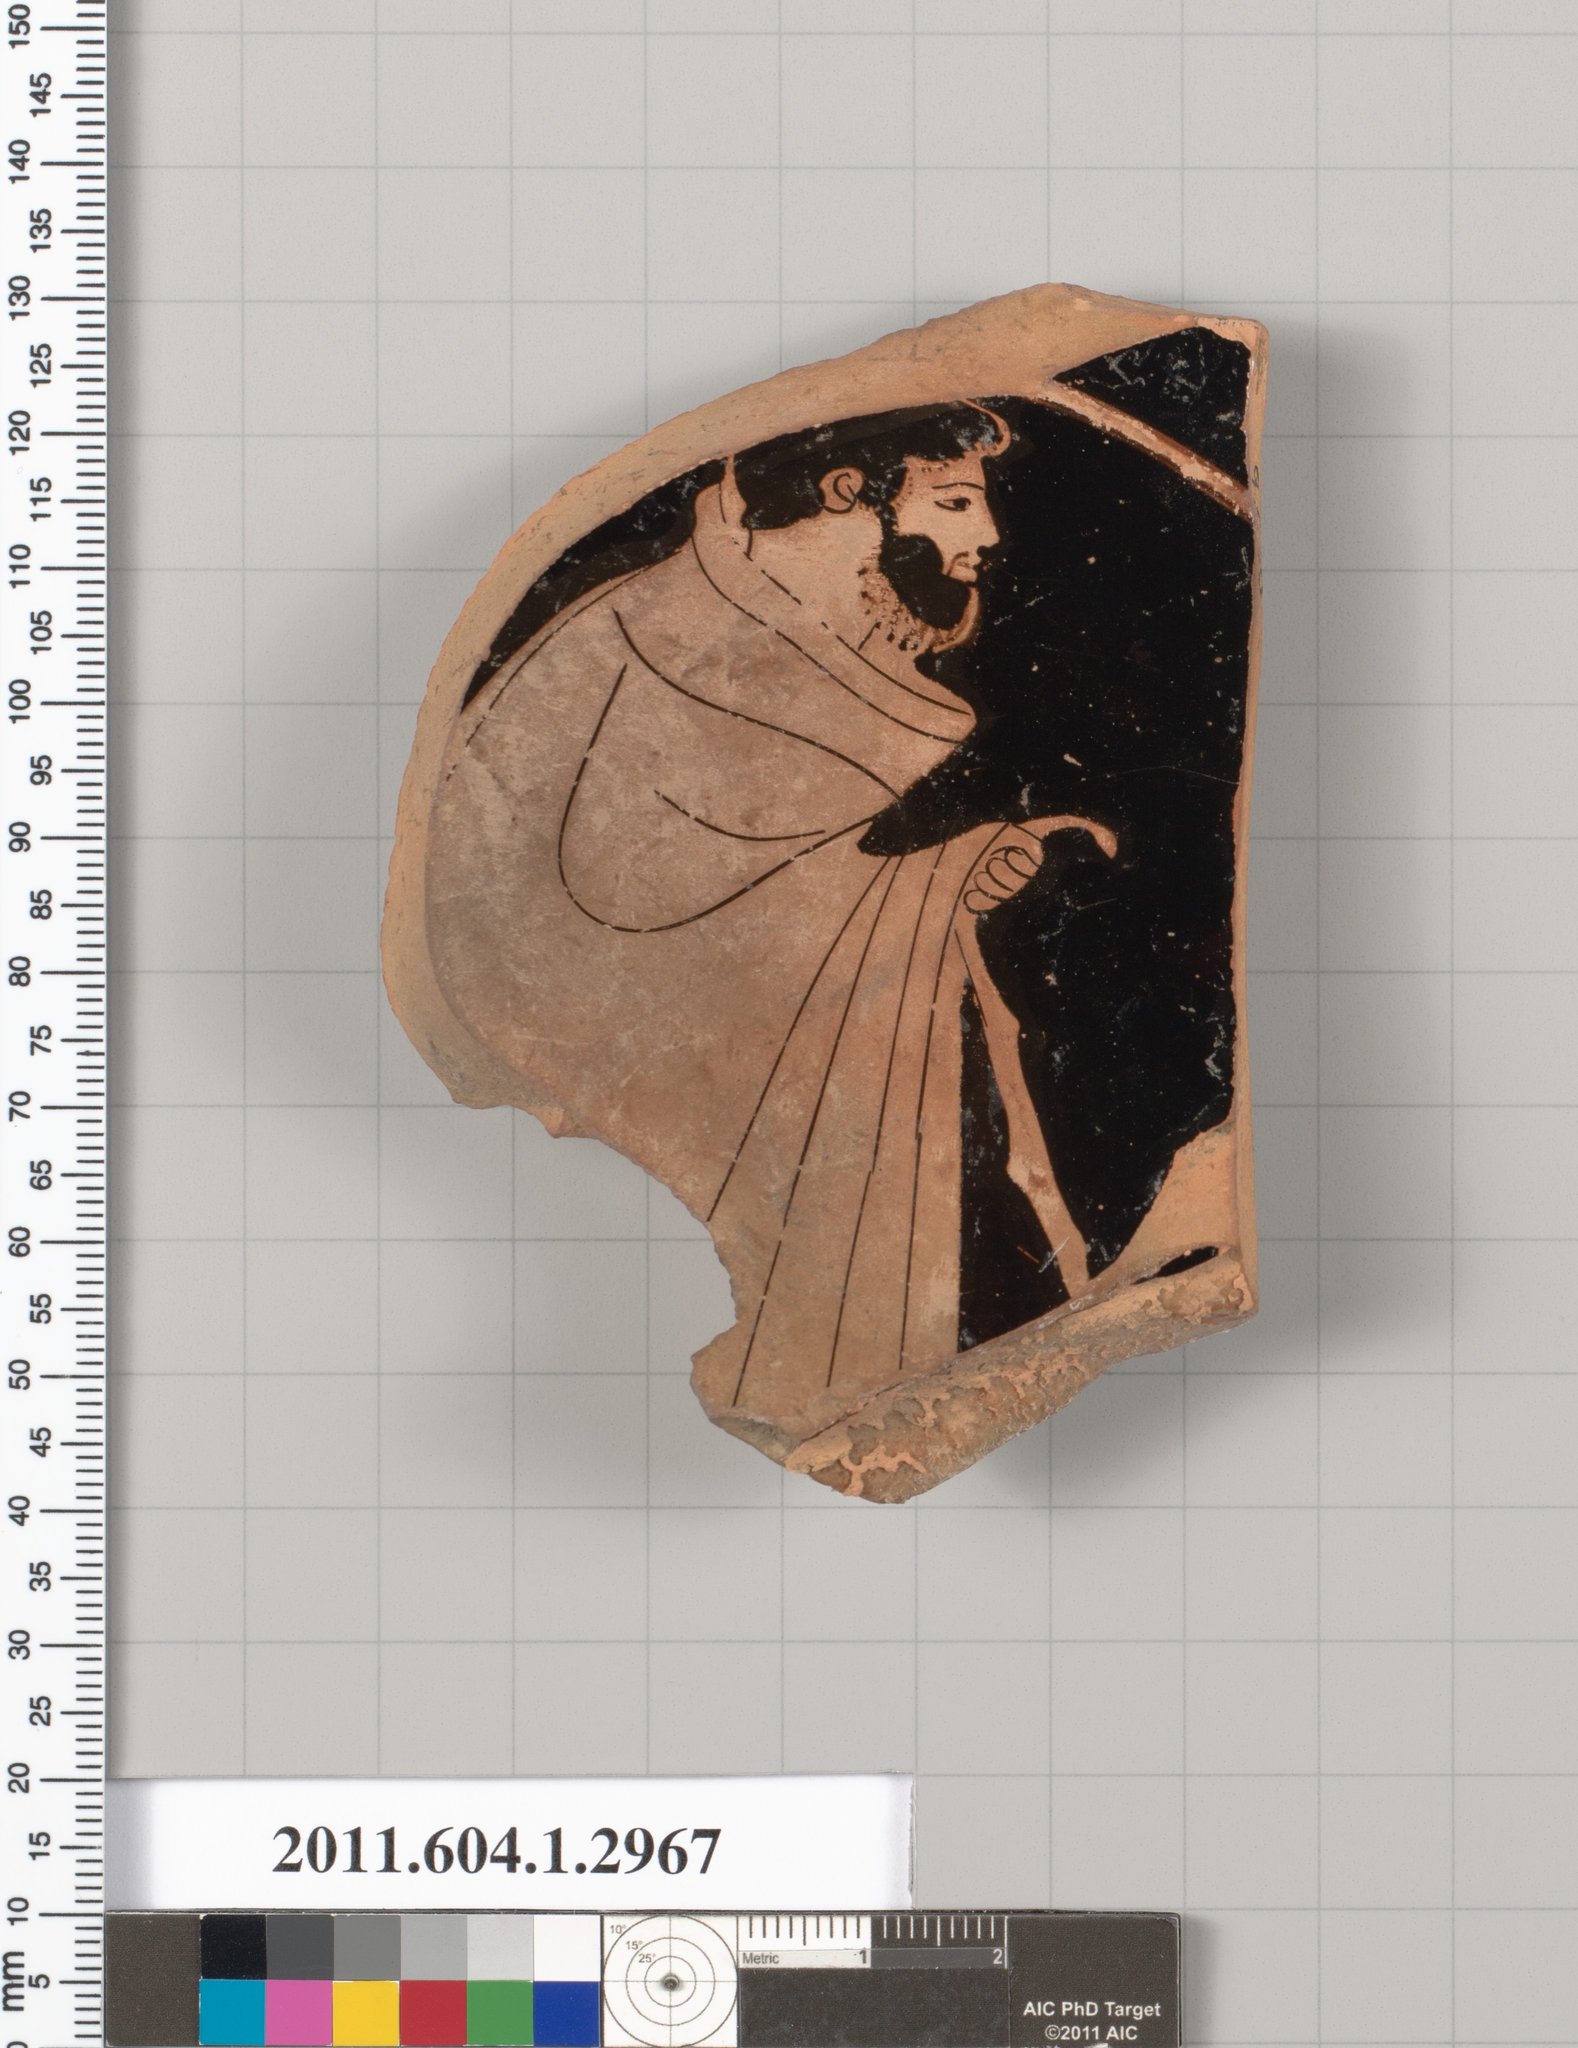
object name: kylix fragment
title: Terracotta fragment of a kylix (drinking cup)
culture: greek, attic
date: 500-480 BCE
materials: terracotta